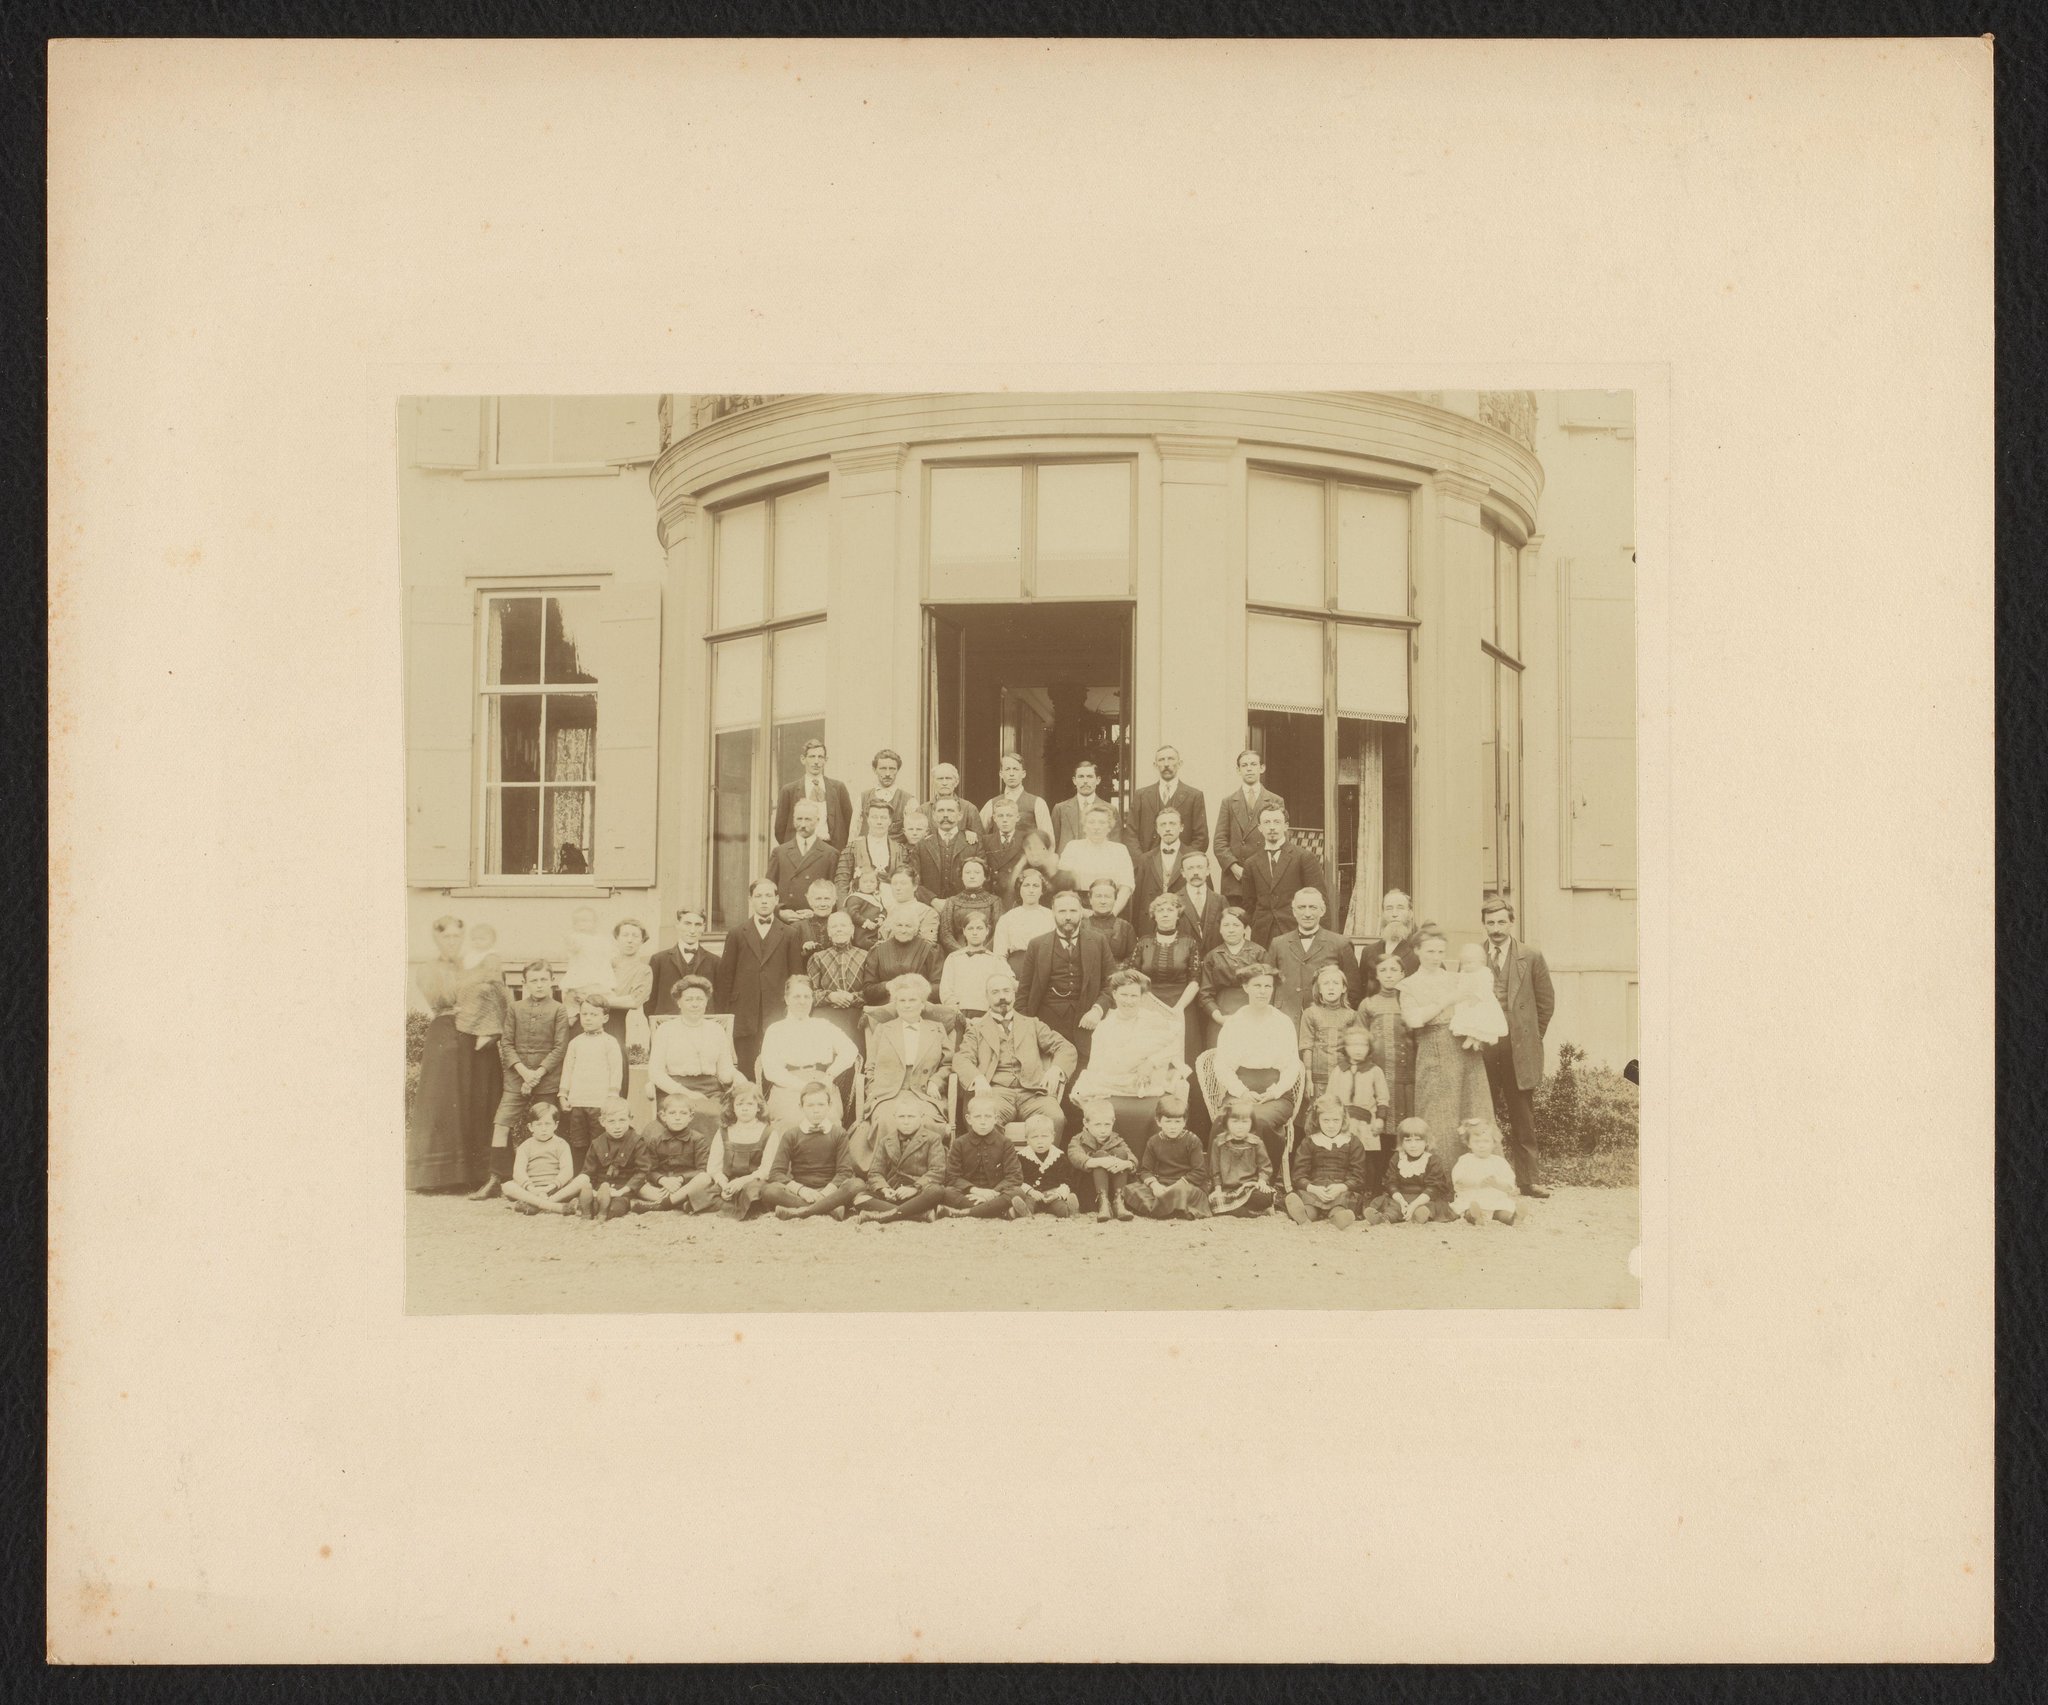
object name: photograph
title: Groepsportret van de familie Kessler op het bordes van huize De Paauw in Wassenaar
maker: Anonymous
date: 1910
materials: paper, cardboard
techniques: gelatin silver print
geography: wassenaar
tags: physicist, margaretha jacoba johanna kessler-de lange (margo), historical persons, anonymous historical persons portrayed in a group, in a group-portrait